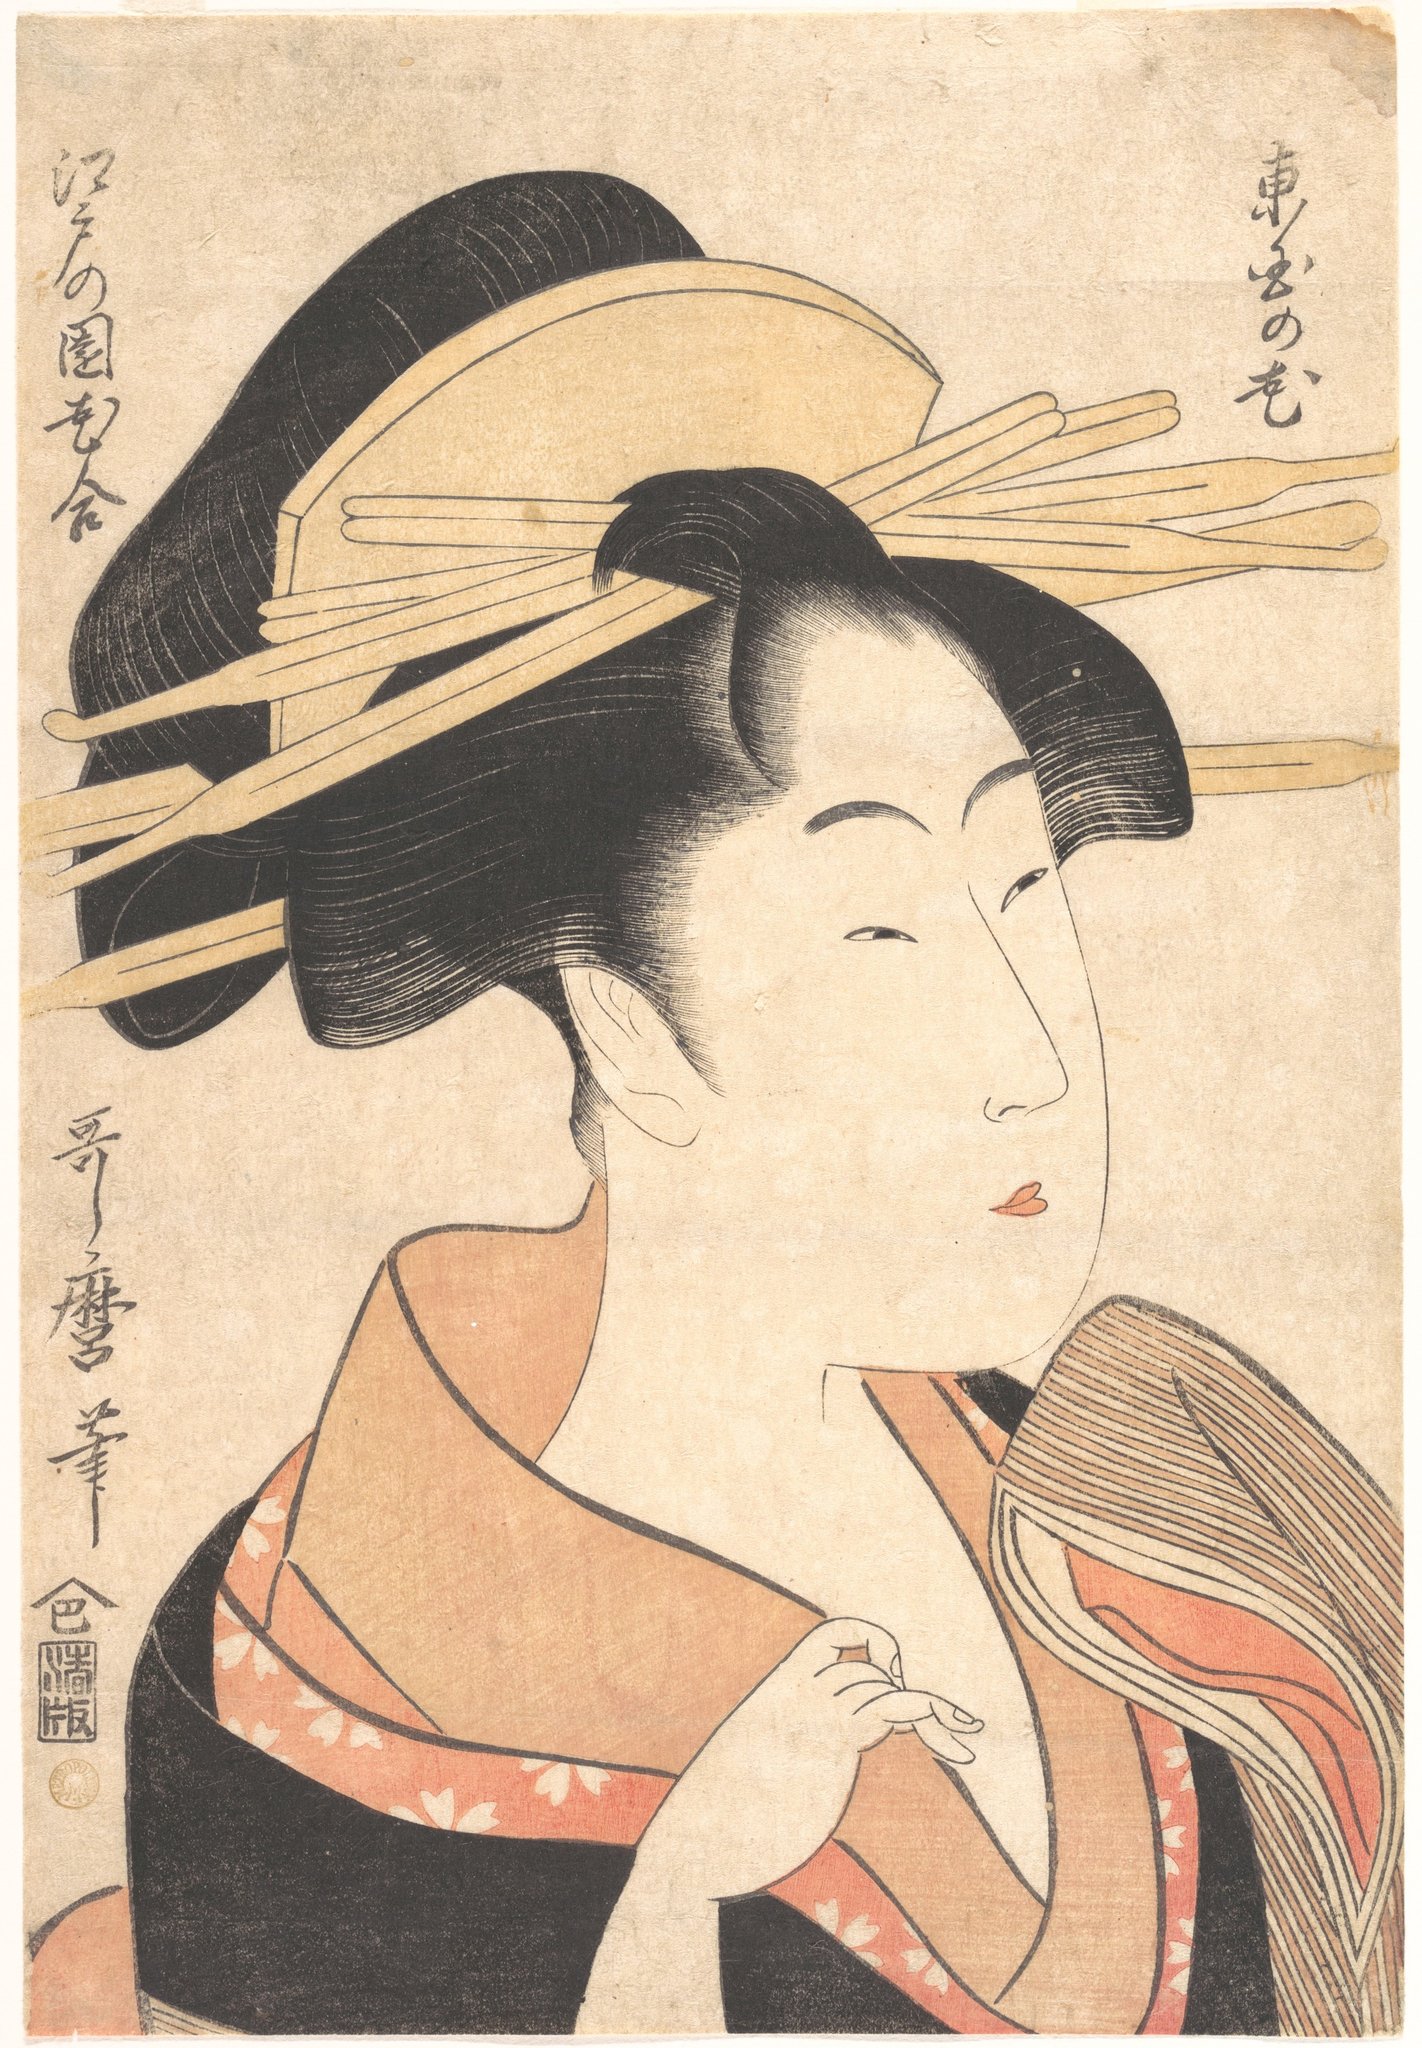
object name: print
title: Azumaya no Hana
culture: japanese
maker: kitagawa utamaro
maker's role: artist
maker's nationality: japanese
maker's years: 1754-1806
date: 1790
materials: ink, paper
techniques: woodblock print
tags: women